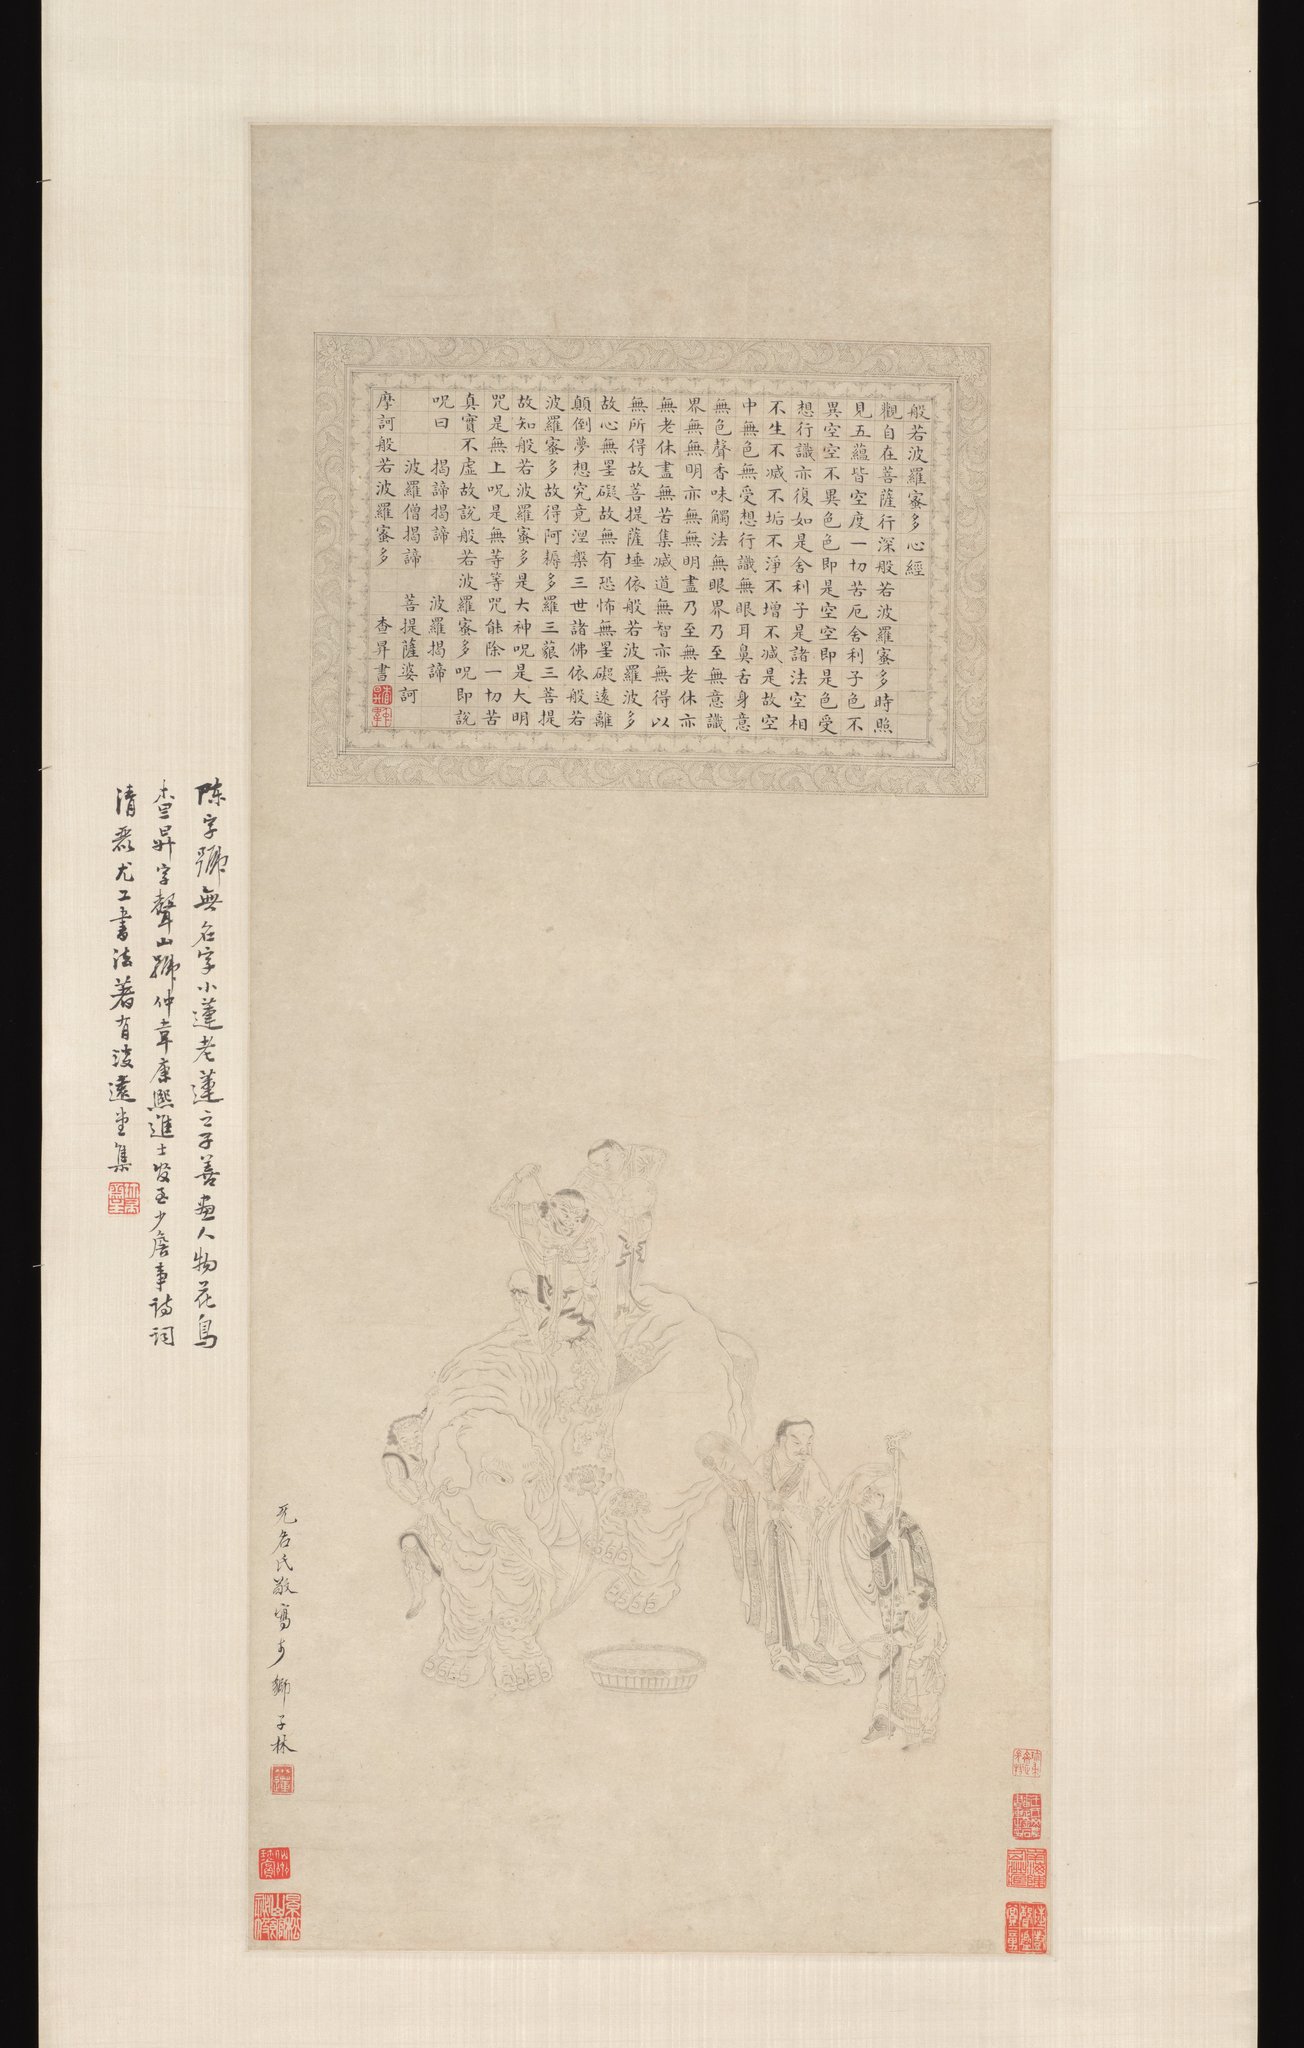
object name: hanging scroll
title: Washing the White Elephant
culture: chinese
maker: chen zi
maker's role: artist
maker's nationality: chinese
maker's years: 1634-1711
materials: ink, paper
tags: elephants